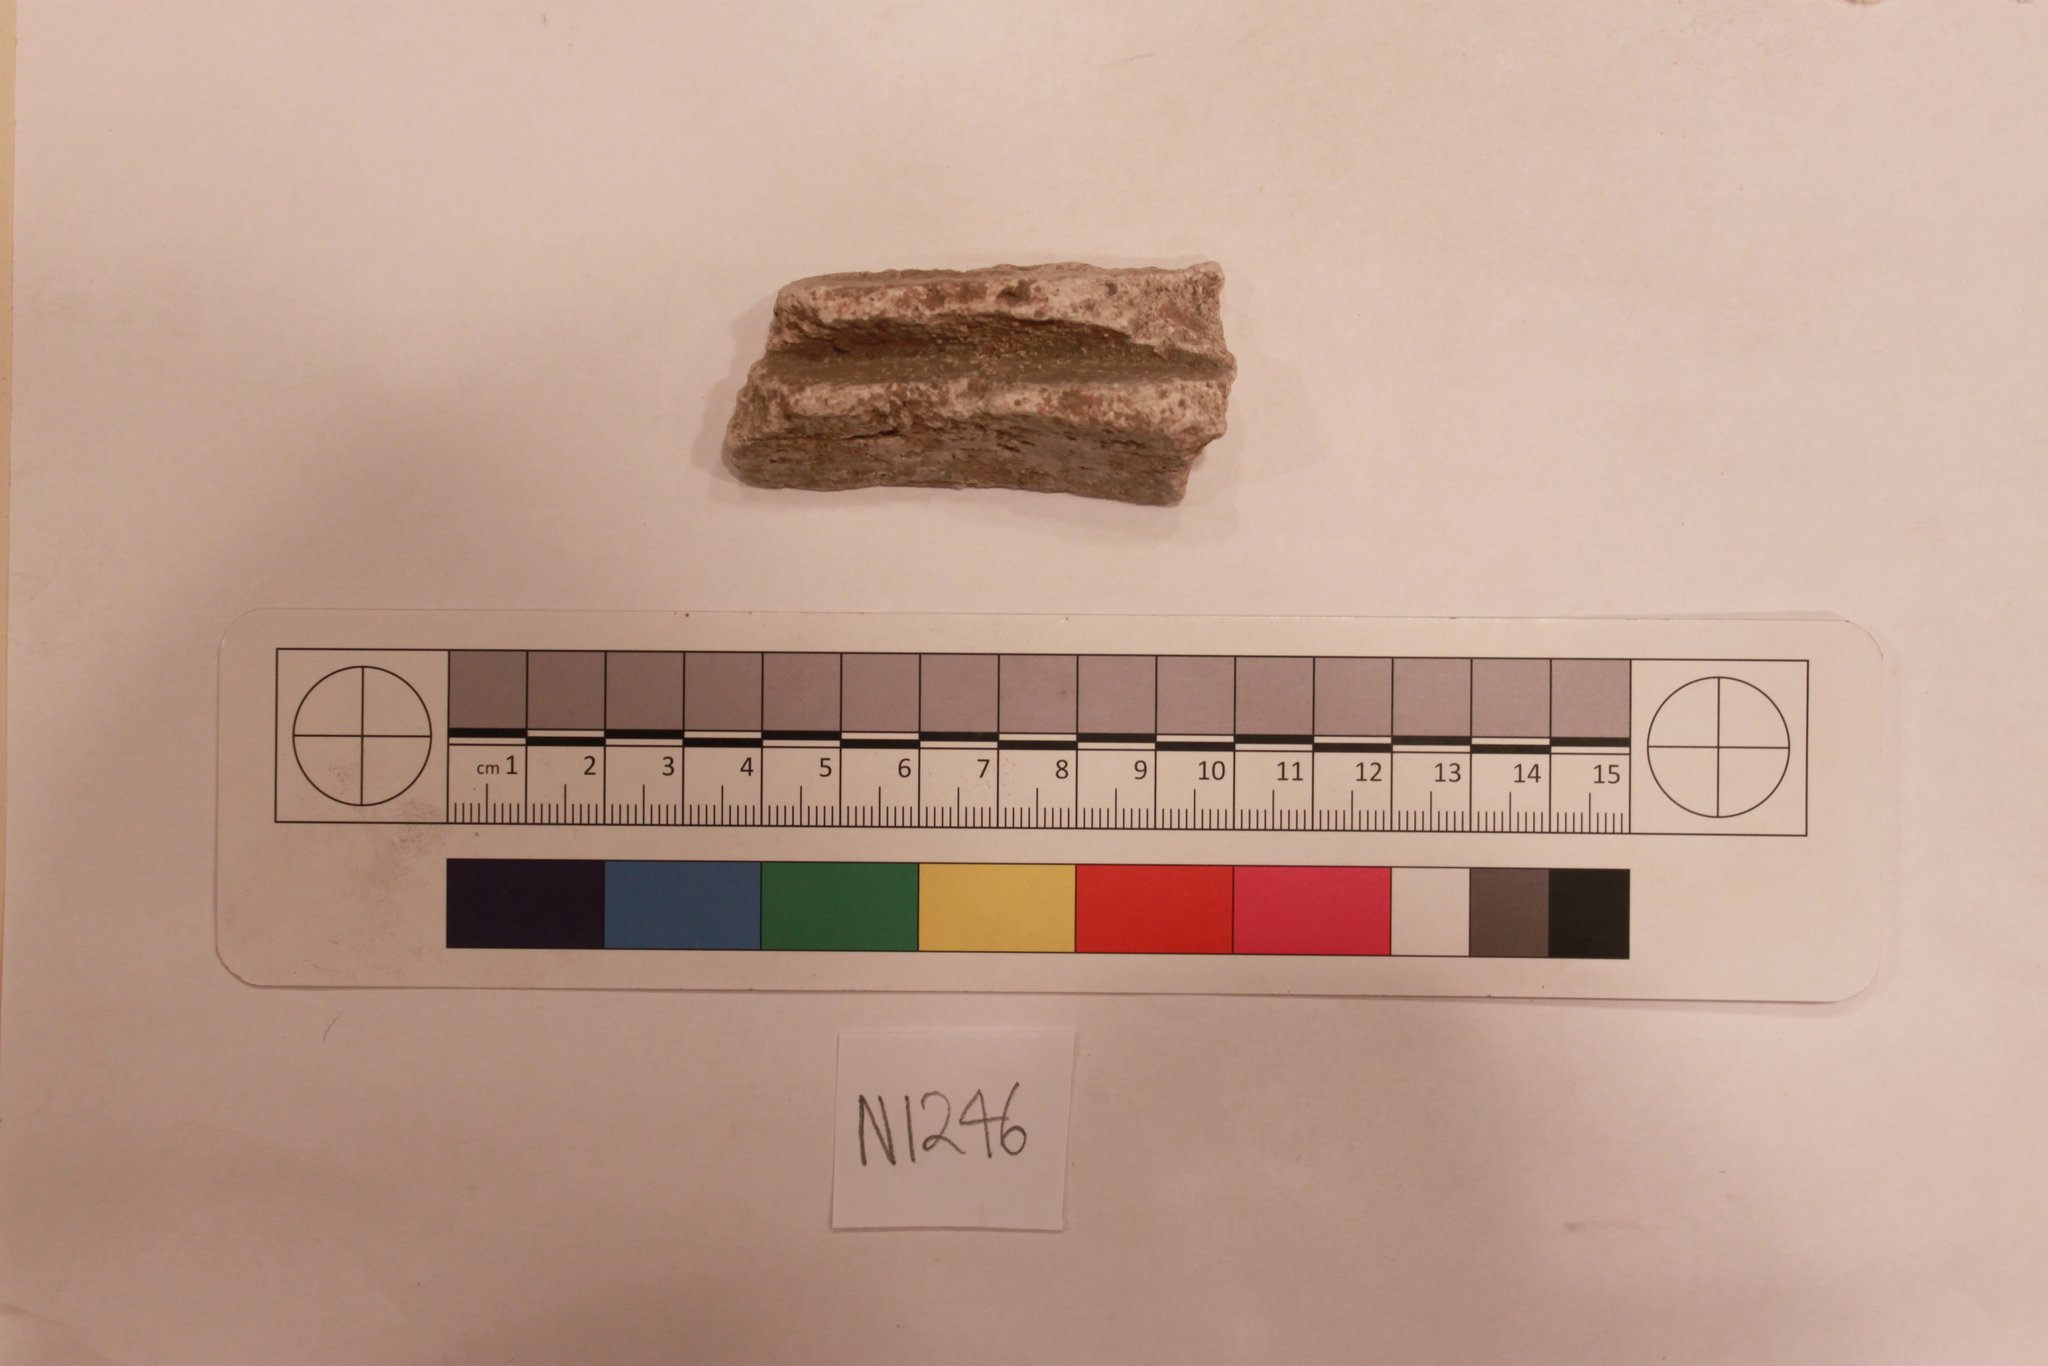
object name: fragment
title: Stucco Fragment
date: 701-1200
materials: plaster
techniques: carving, painting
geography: iran